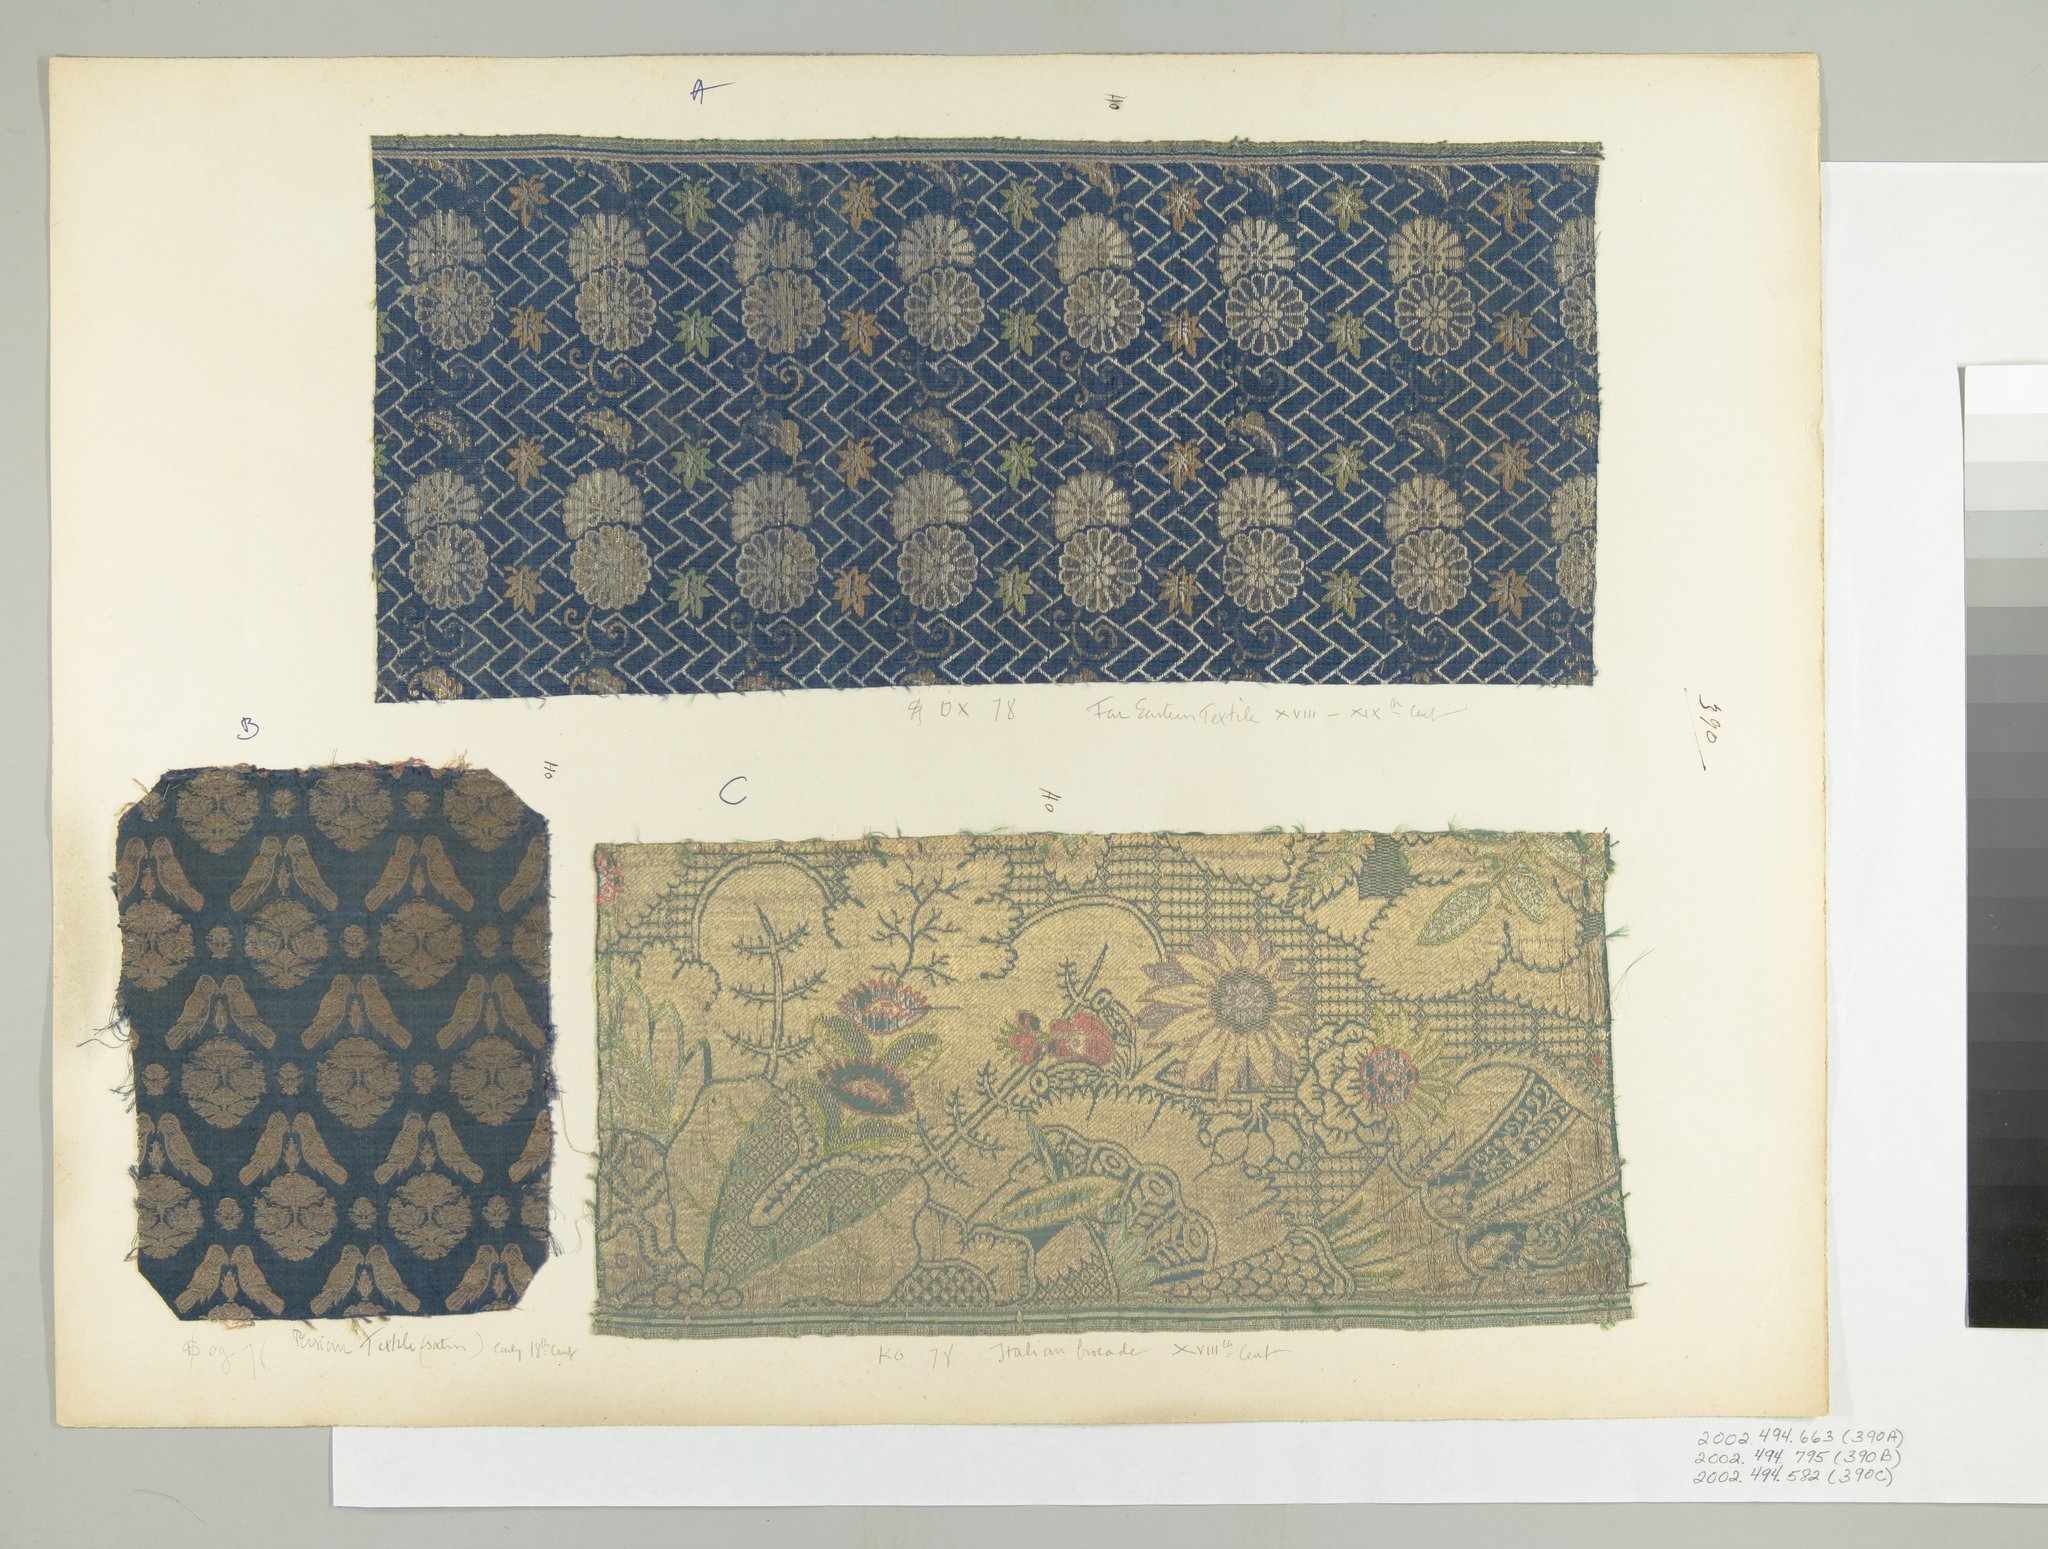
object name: piece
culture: japanese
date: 1615-1868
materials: metal thread, silk